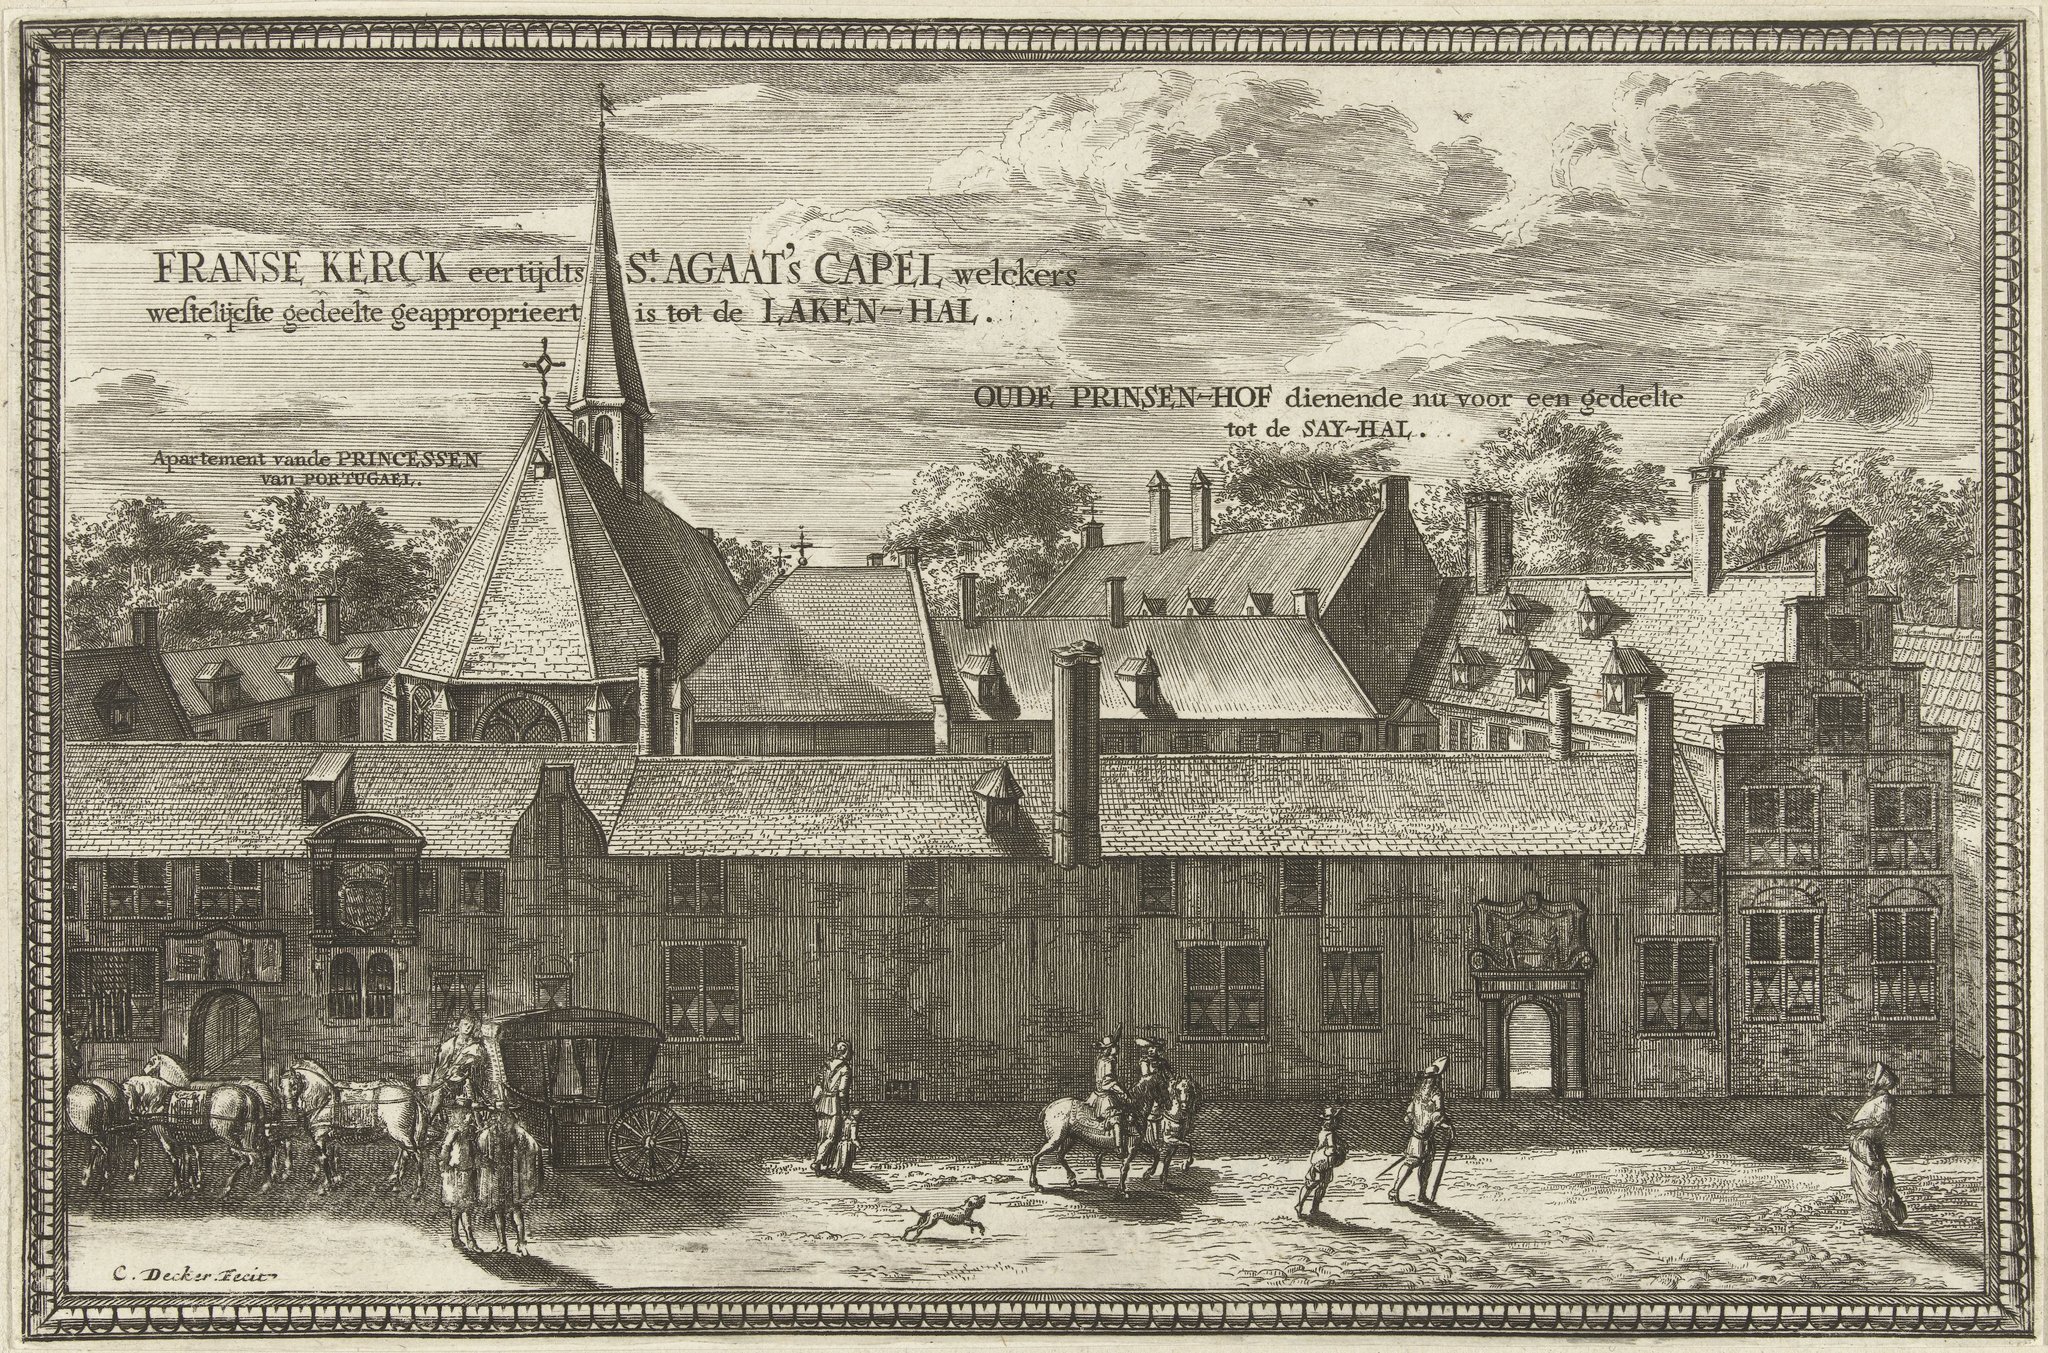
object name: print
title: Franse Kerck eertijds St. Agaat's Capel welckers westelijcste gedeelte geapproprieert is tot de Laken-Hal / Oude Prinsen-hof dienende nu voor een gedeelte tot de Say-hal / Apartement vande princessen van Portugael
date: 1678-1703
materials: paper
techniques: etching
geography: amsterdam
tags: abbey, monastery, convent ~ roman catholic church, church (exterior), exterior ~ representation of a building, street (+ city(-scape) with figures, staffage), delft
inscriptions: collector's mark: Lugt 195, collector's mark: Lugt 2228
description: Deze prent is in 1678 voor het eerst uitgegeven als onderdeel van de rand van de zogenaamde Kaart Figuratief (Caerte figuratyff / Kaerte figuratyf) van Delft, een wandkaart van Delft. Deze kaart bestaat uit een plattegrond van Delft (RP-P-AO-11-8A) met daaromheen een rand. De rand bestaat uit een profiel van Delft (RP-P-AO-11-11), een profiel van Delfshaven met daaronder de wapenschilden van de burgemeesters van de stad (RP-P-AO-13-51-1 en RP-P-AO-13-51-2), 24 kleinere prenten (kaarten, afbeeldingen van gebouwen en graven van bekende personen, o.a. huidige prent, RP-P-AO-11-15, RP-P-AO-11-16, RP-P-AO-11-17, RP-P-AO-11-18, RP-P-AO-11-19, RP-P-AO-11-20, RP-P-AO-11-21, RP-P-AO-11-23, RP-P-AO-11-24, RP-P-AO-11-27, RP-P-AO-11-29, RP-P-AO-11-30, RP-P-AO-11-31, RP-P-AO-11-33C, RP-P-AO-11-34, RP-P-AO-11-35, RP-P-AO-11-35-2, RP-P-AO-13-49, RP-P-AO-13-52, RP-P-AO-13-53, RP-P-AO-13-54-1 en RP-P-1909-6463) en een beschrijving van de stad (RP-P-AO-11-8E). De eerste druk van deze Kaart Figuratief (1678) werd, in opdracht van het Delftse stadsbestuur, verzorgd door Pieter Smith. In 1680 leverde Smith ook vijfhonderd afdrukken van de randprenten die bestemd waren voor Dirk Evertsz. Bleyswijcks 'Beschryvinge der stadt Delft' (1667) en het tweede deel: 'Vervolg van de beschryvinge der stadt Delft' (1680). In het tweede deel zat een bijlage waarin beschreven staat welke prenten waar in het eerste en tweede deel ingebonden dienden te worden. Een deel van de prenten was dus bestemd voor het in 1667 verschenen eerste deel en kon met het verschijnen van het tweede deel in 1680 alsnog worden ingebonden. Hierdoor wordt vaak gedacht dat de prenten uit het eerste deel dateren uit 1667, hetgeen niet klopt. De huidige prent is zodoende ook gebruikt in: Bleyswijck, Dirk Evertsz. Beschryvinge der stadt Delft, betreffende des selfs situatie, oorsprong en ouderdom, opkomst en voortgangh (…). Delft: Arnold Bon, 1667 (prenten vanaf 1680 ingebonden), p. 454. Pieter Mortier (I) verzorgde in 1703, tevens in opdracht van het stadsbestuur, een tweede uitgave van de Kaart Figuratief. Voor deze druk bracht graveur Thomas van der Wilt enkele aanpassingen aan op de platen van de plattegrond. De randplaten lijken, op de plaat met de wapens van de burgemeesters na, ongewijzigd te zijn gebleven. De plattegrond is in 1752, waarschijnlijk zonder de randprenten, opnieuw uitgegeven. Een deel van de randprenten, waaronder de huidige prent, is in 1729 opnieuw gebruikt in: Beschryving der stadt Delft, behelzende een zeer naaukeurige en uitvoerige verhandeling van deszelfs eerste oorsprong (…). Delft: Reinier Boitet, 1729. Op twee na (die van de Nieuwe en Oude Kerk) paste Boitet de platen aan, waardoor van deze prenten een tweede staat ontstond. Of de huidige prent is gebruikt als onderdeel van de rand van de Kaart Figuratief uit 1678 of 1703, of is gebruikt in 'Beschryvinge der stadt Delft' (1667, prenten 1680), is niet na te gaan.